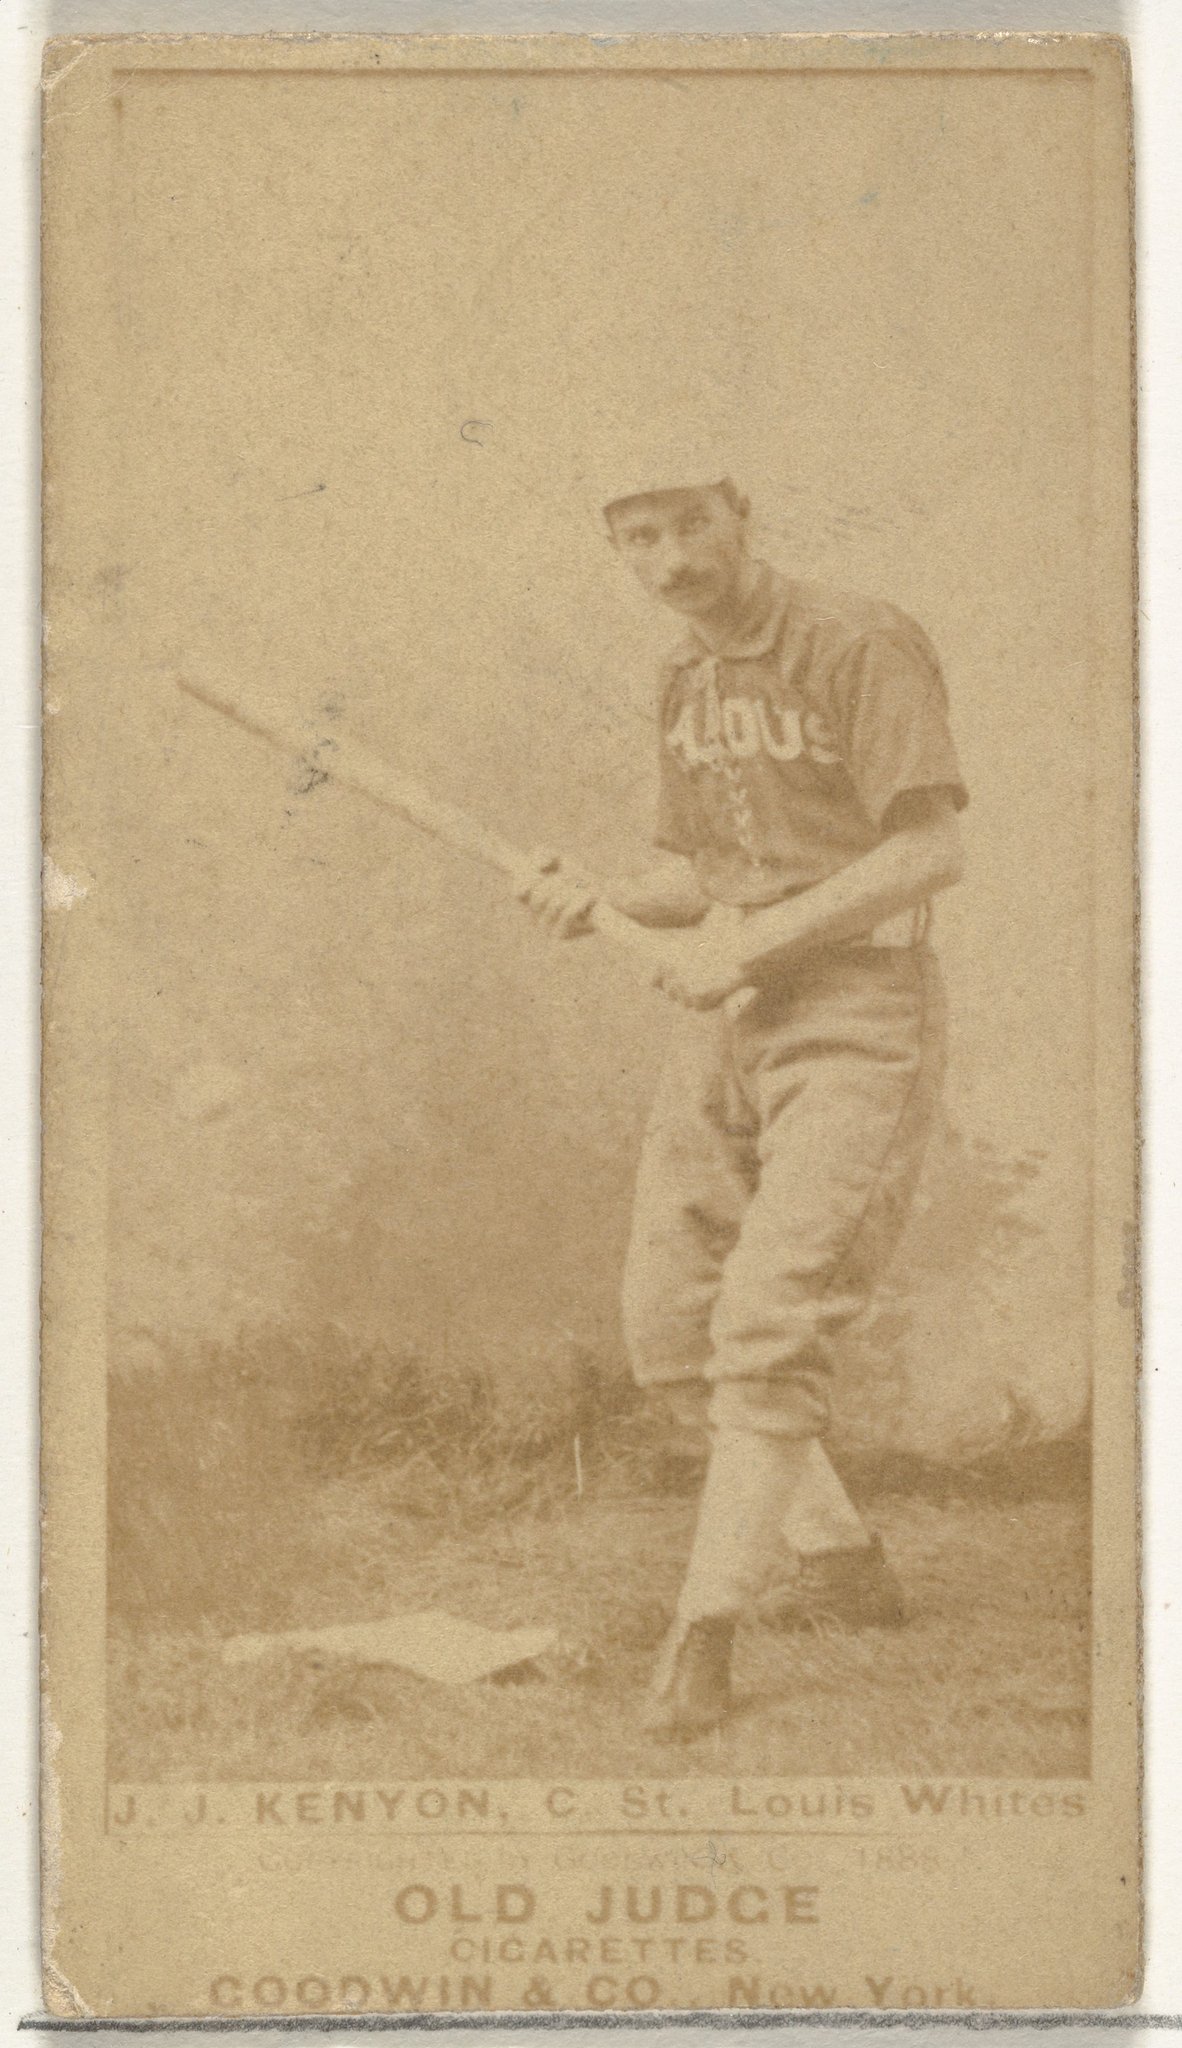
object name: baseball card, photograph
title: Kenyon, Catcher, St. Louis Whites, from the Old Judge series (N172) for Old Judge Cigarettes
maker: goodwin & company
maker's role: publisher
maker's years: 1850-1950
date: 1887-1890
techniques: albumen silver print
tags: men,portraits,baseball,athletes